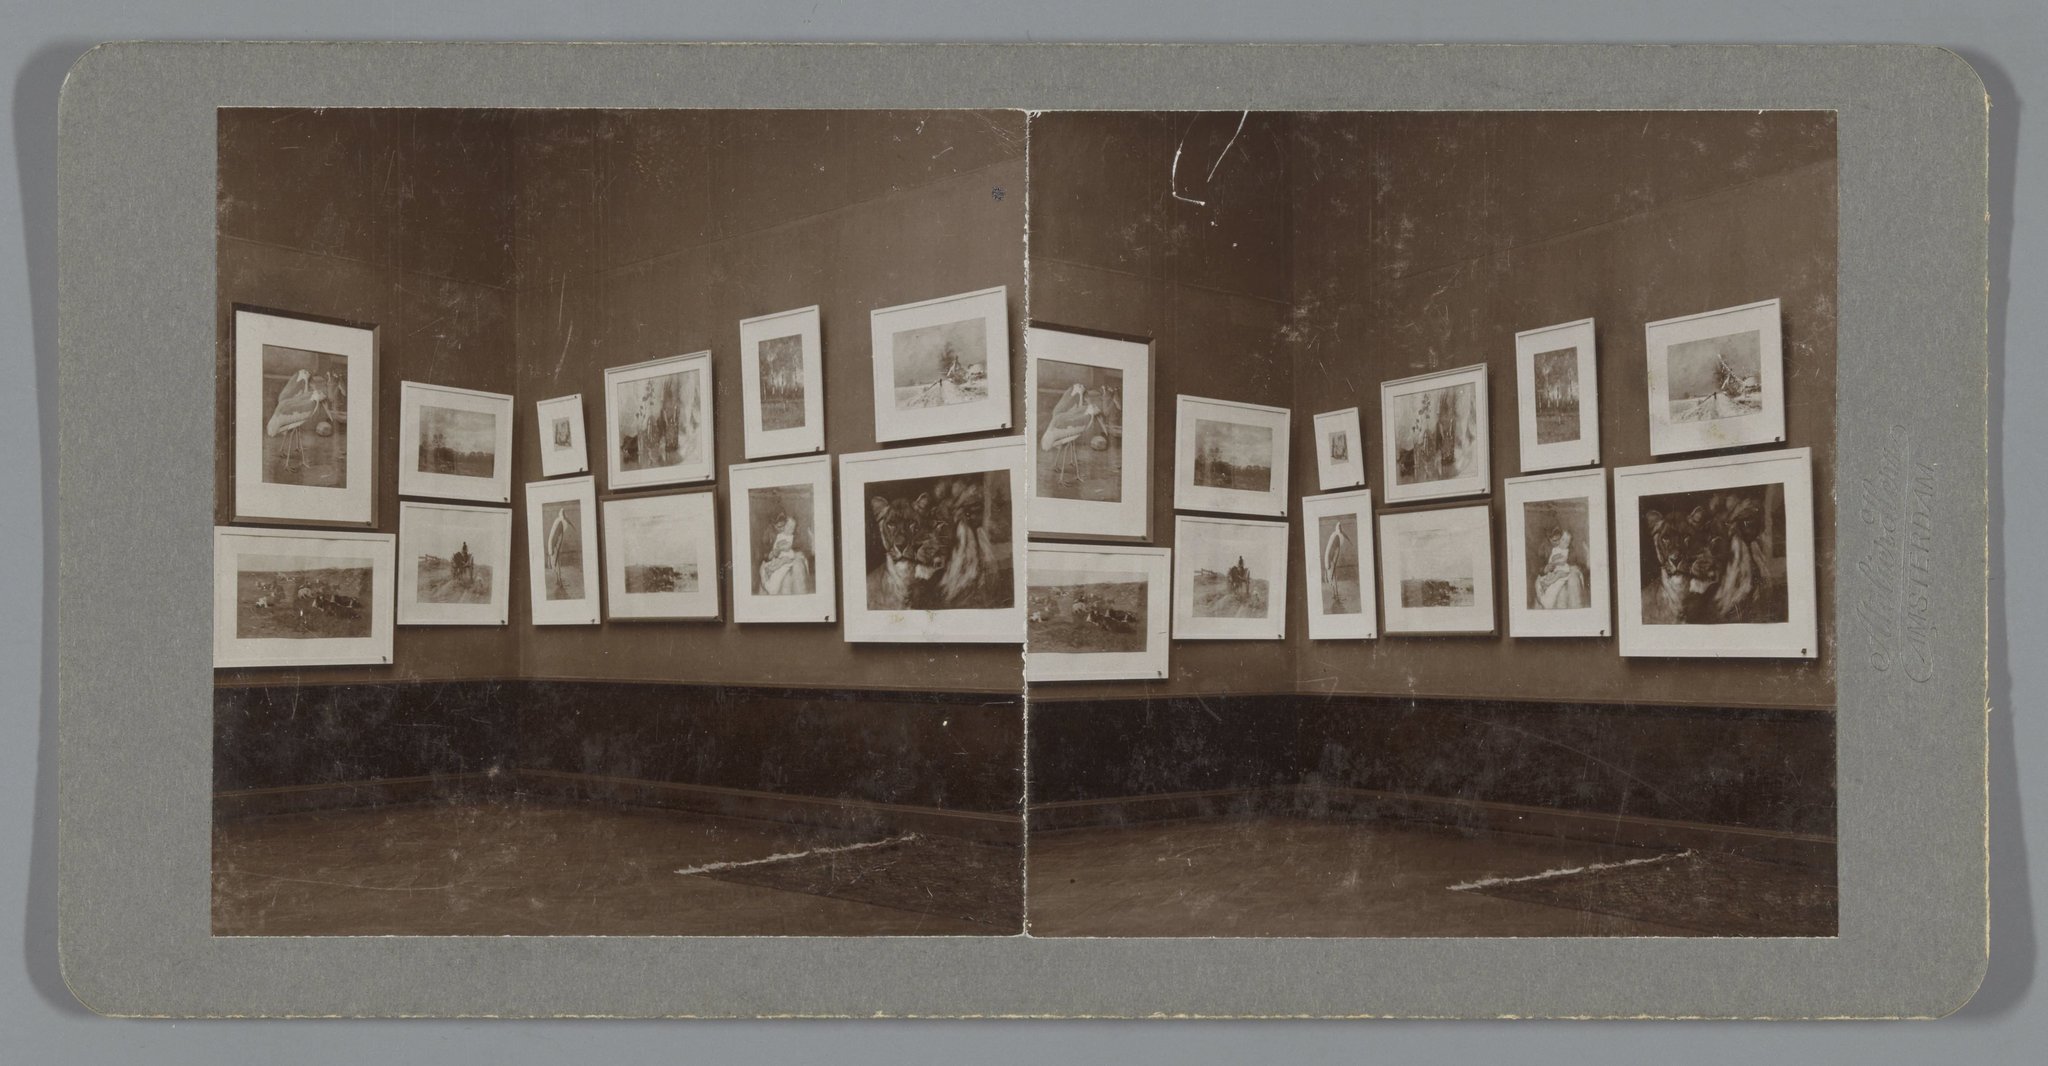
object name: stereograph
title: Gezicht in een zaal van het Stedelijk Museum, Amsterdam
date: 1902-1920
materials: paper, cardboard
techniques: gelatin silver print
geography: amsterdam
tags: collection, exhibition, show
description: Tijdens een tentoonstelling van de Vereeniging tot het Vormen van eene openbare verzameling van Hedendaagsche Kunst (VVHK, ook wel de 'vereeniging met de lange naam' genoemd).